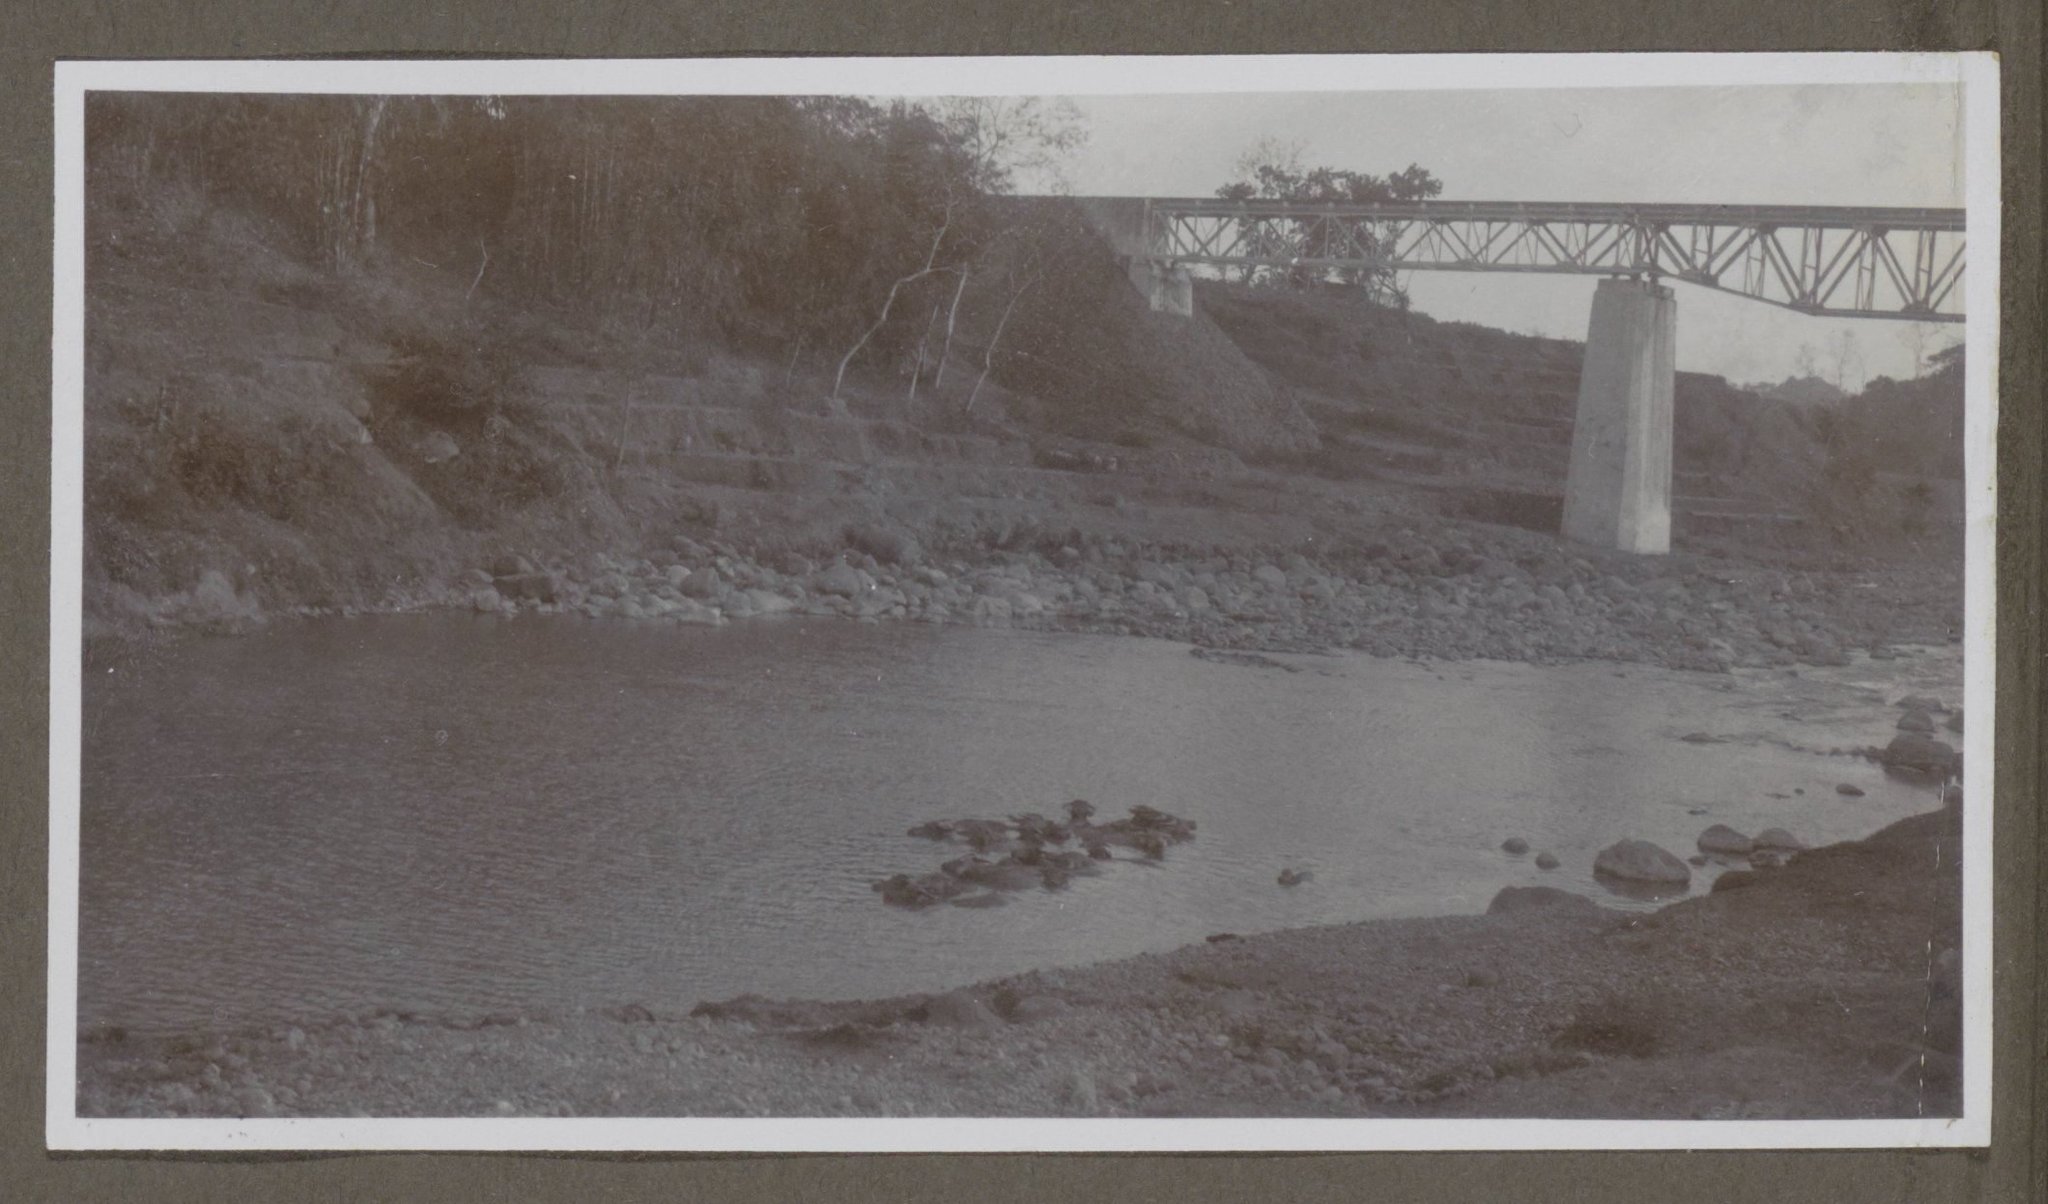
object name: photograph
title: Rivier met een brug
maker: Anonymous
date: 1920-1930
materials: photographic support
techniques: gelatin silver print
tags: landscape with bridge, viaduct or aqueduct, dutch east indies, the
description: Onderdeel van familiealbum Nederlands-Indië.